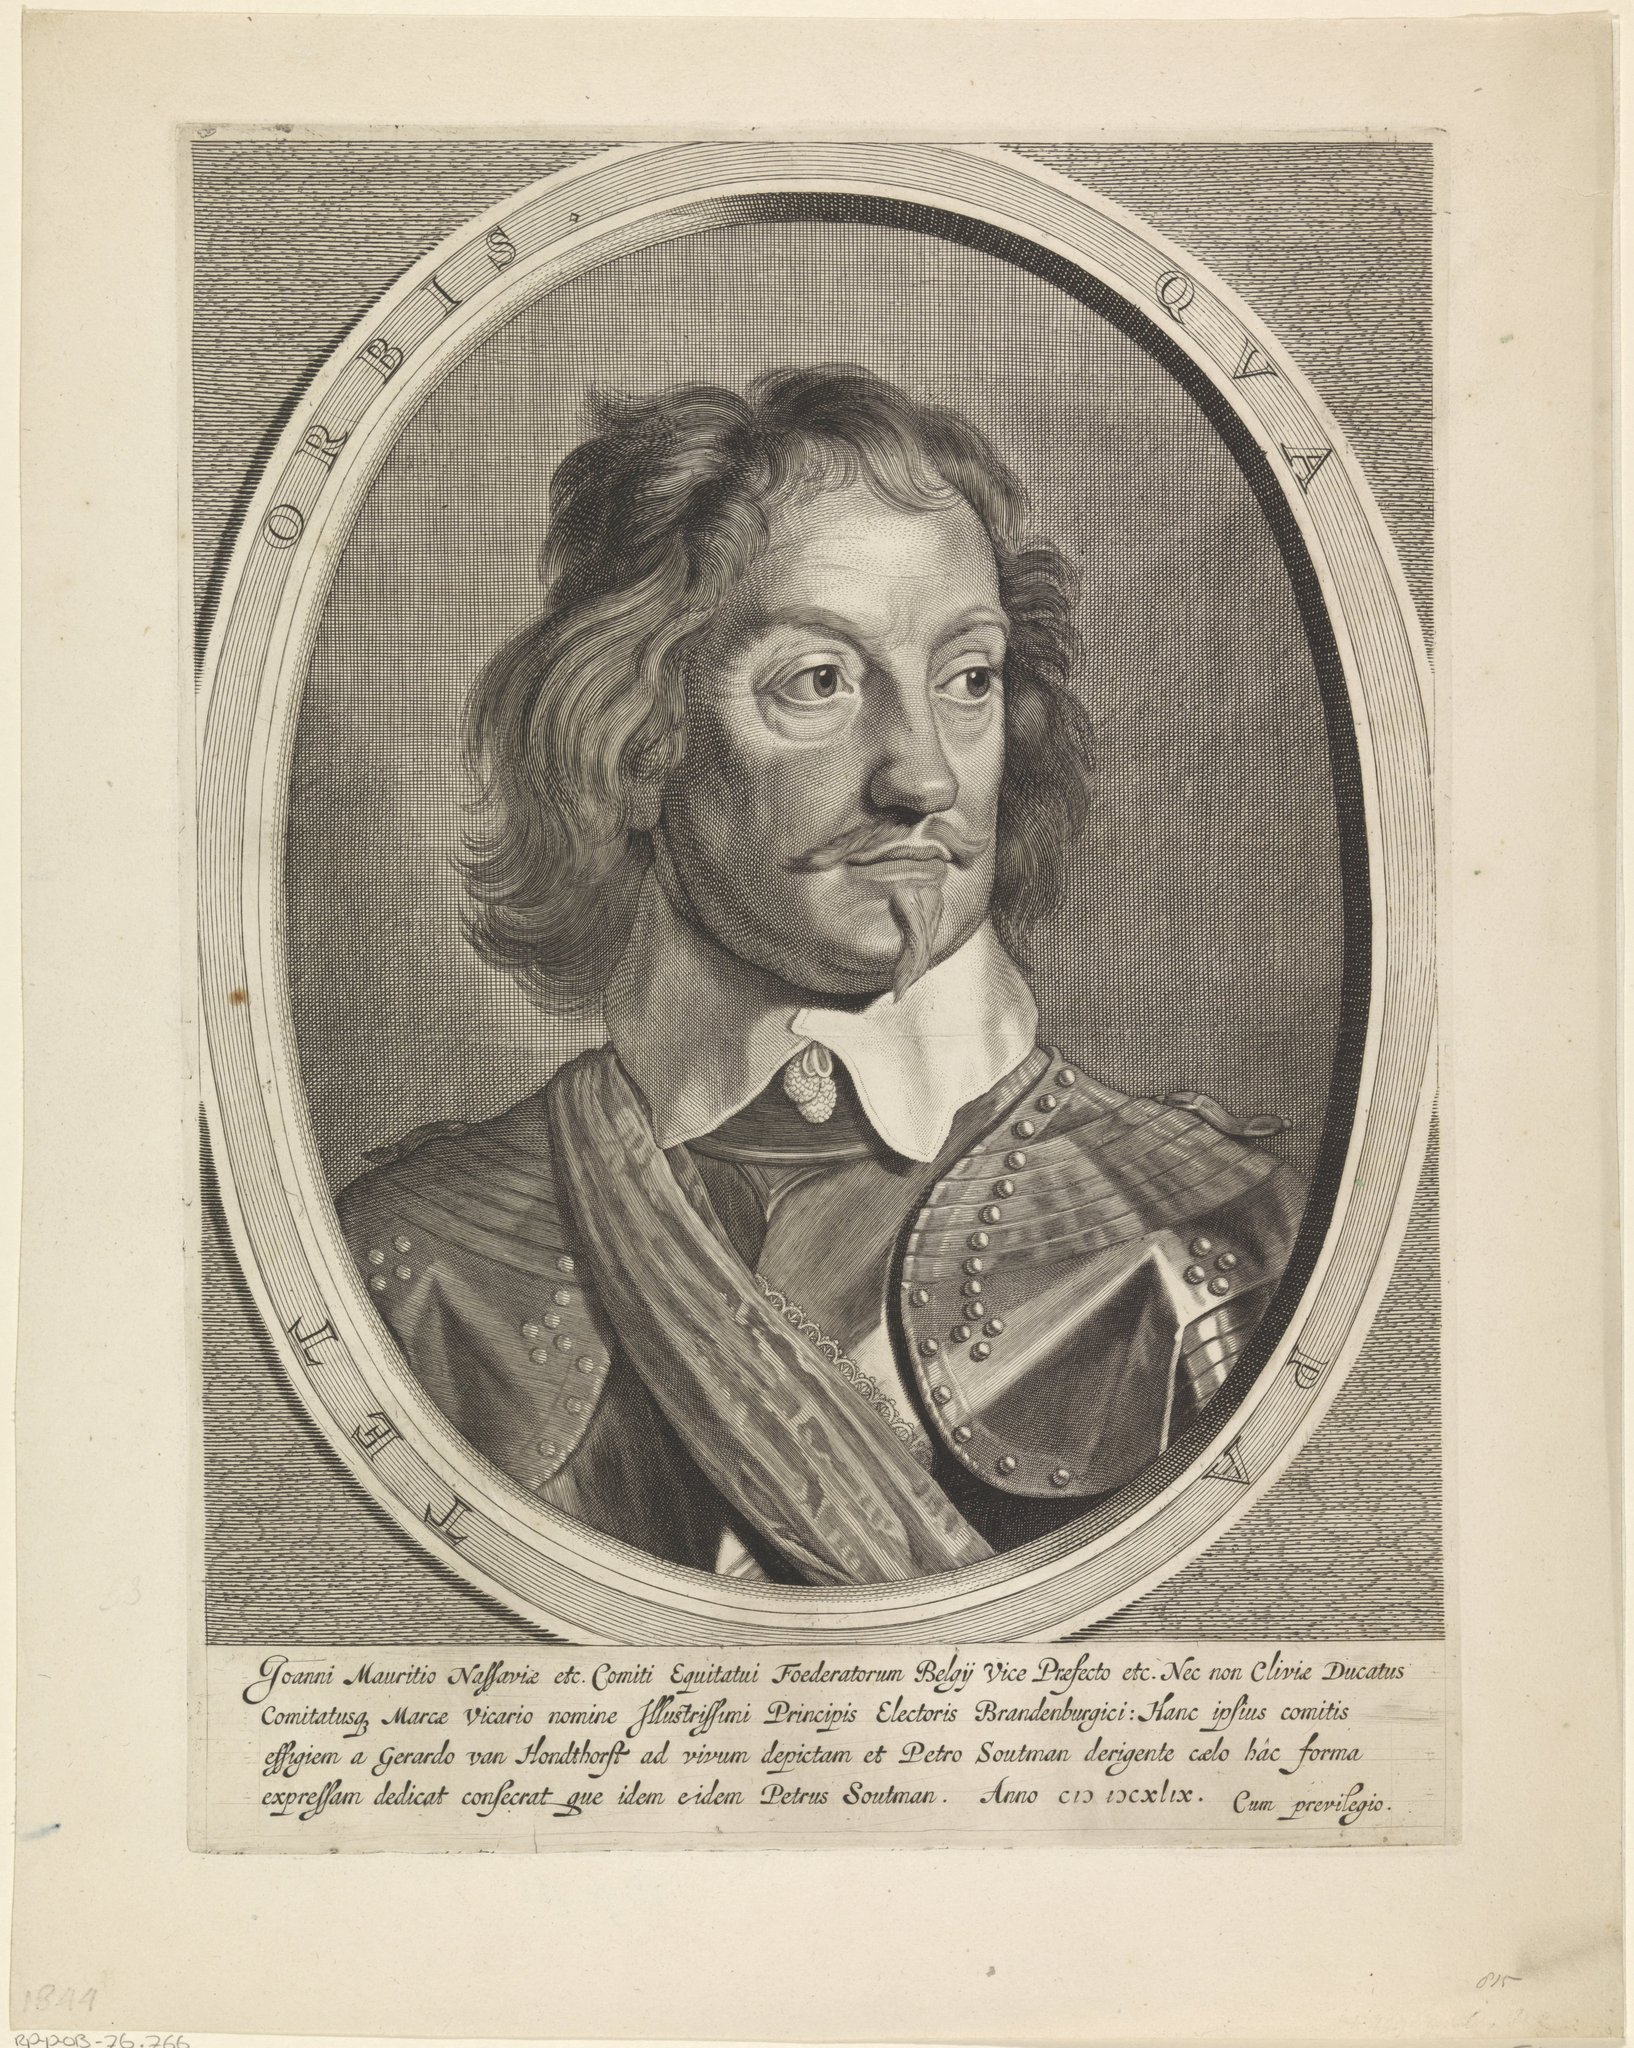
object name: print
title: Portret van Johan Maurits, graaf van Nassau-Siegen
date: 1649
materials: paper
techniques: engraving, etching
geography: haarlem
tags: earl, johan maurits graaf van nassau-siegen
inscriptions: collector's mark: Lugt 963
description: De hier vermelde titel verwijst naar de hoogst verkregen titel van de geportretteerde, niet per se naar de titel die de geportretteerde op deze voorstelling draagt.